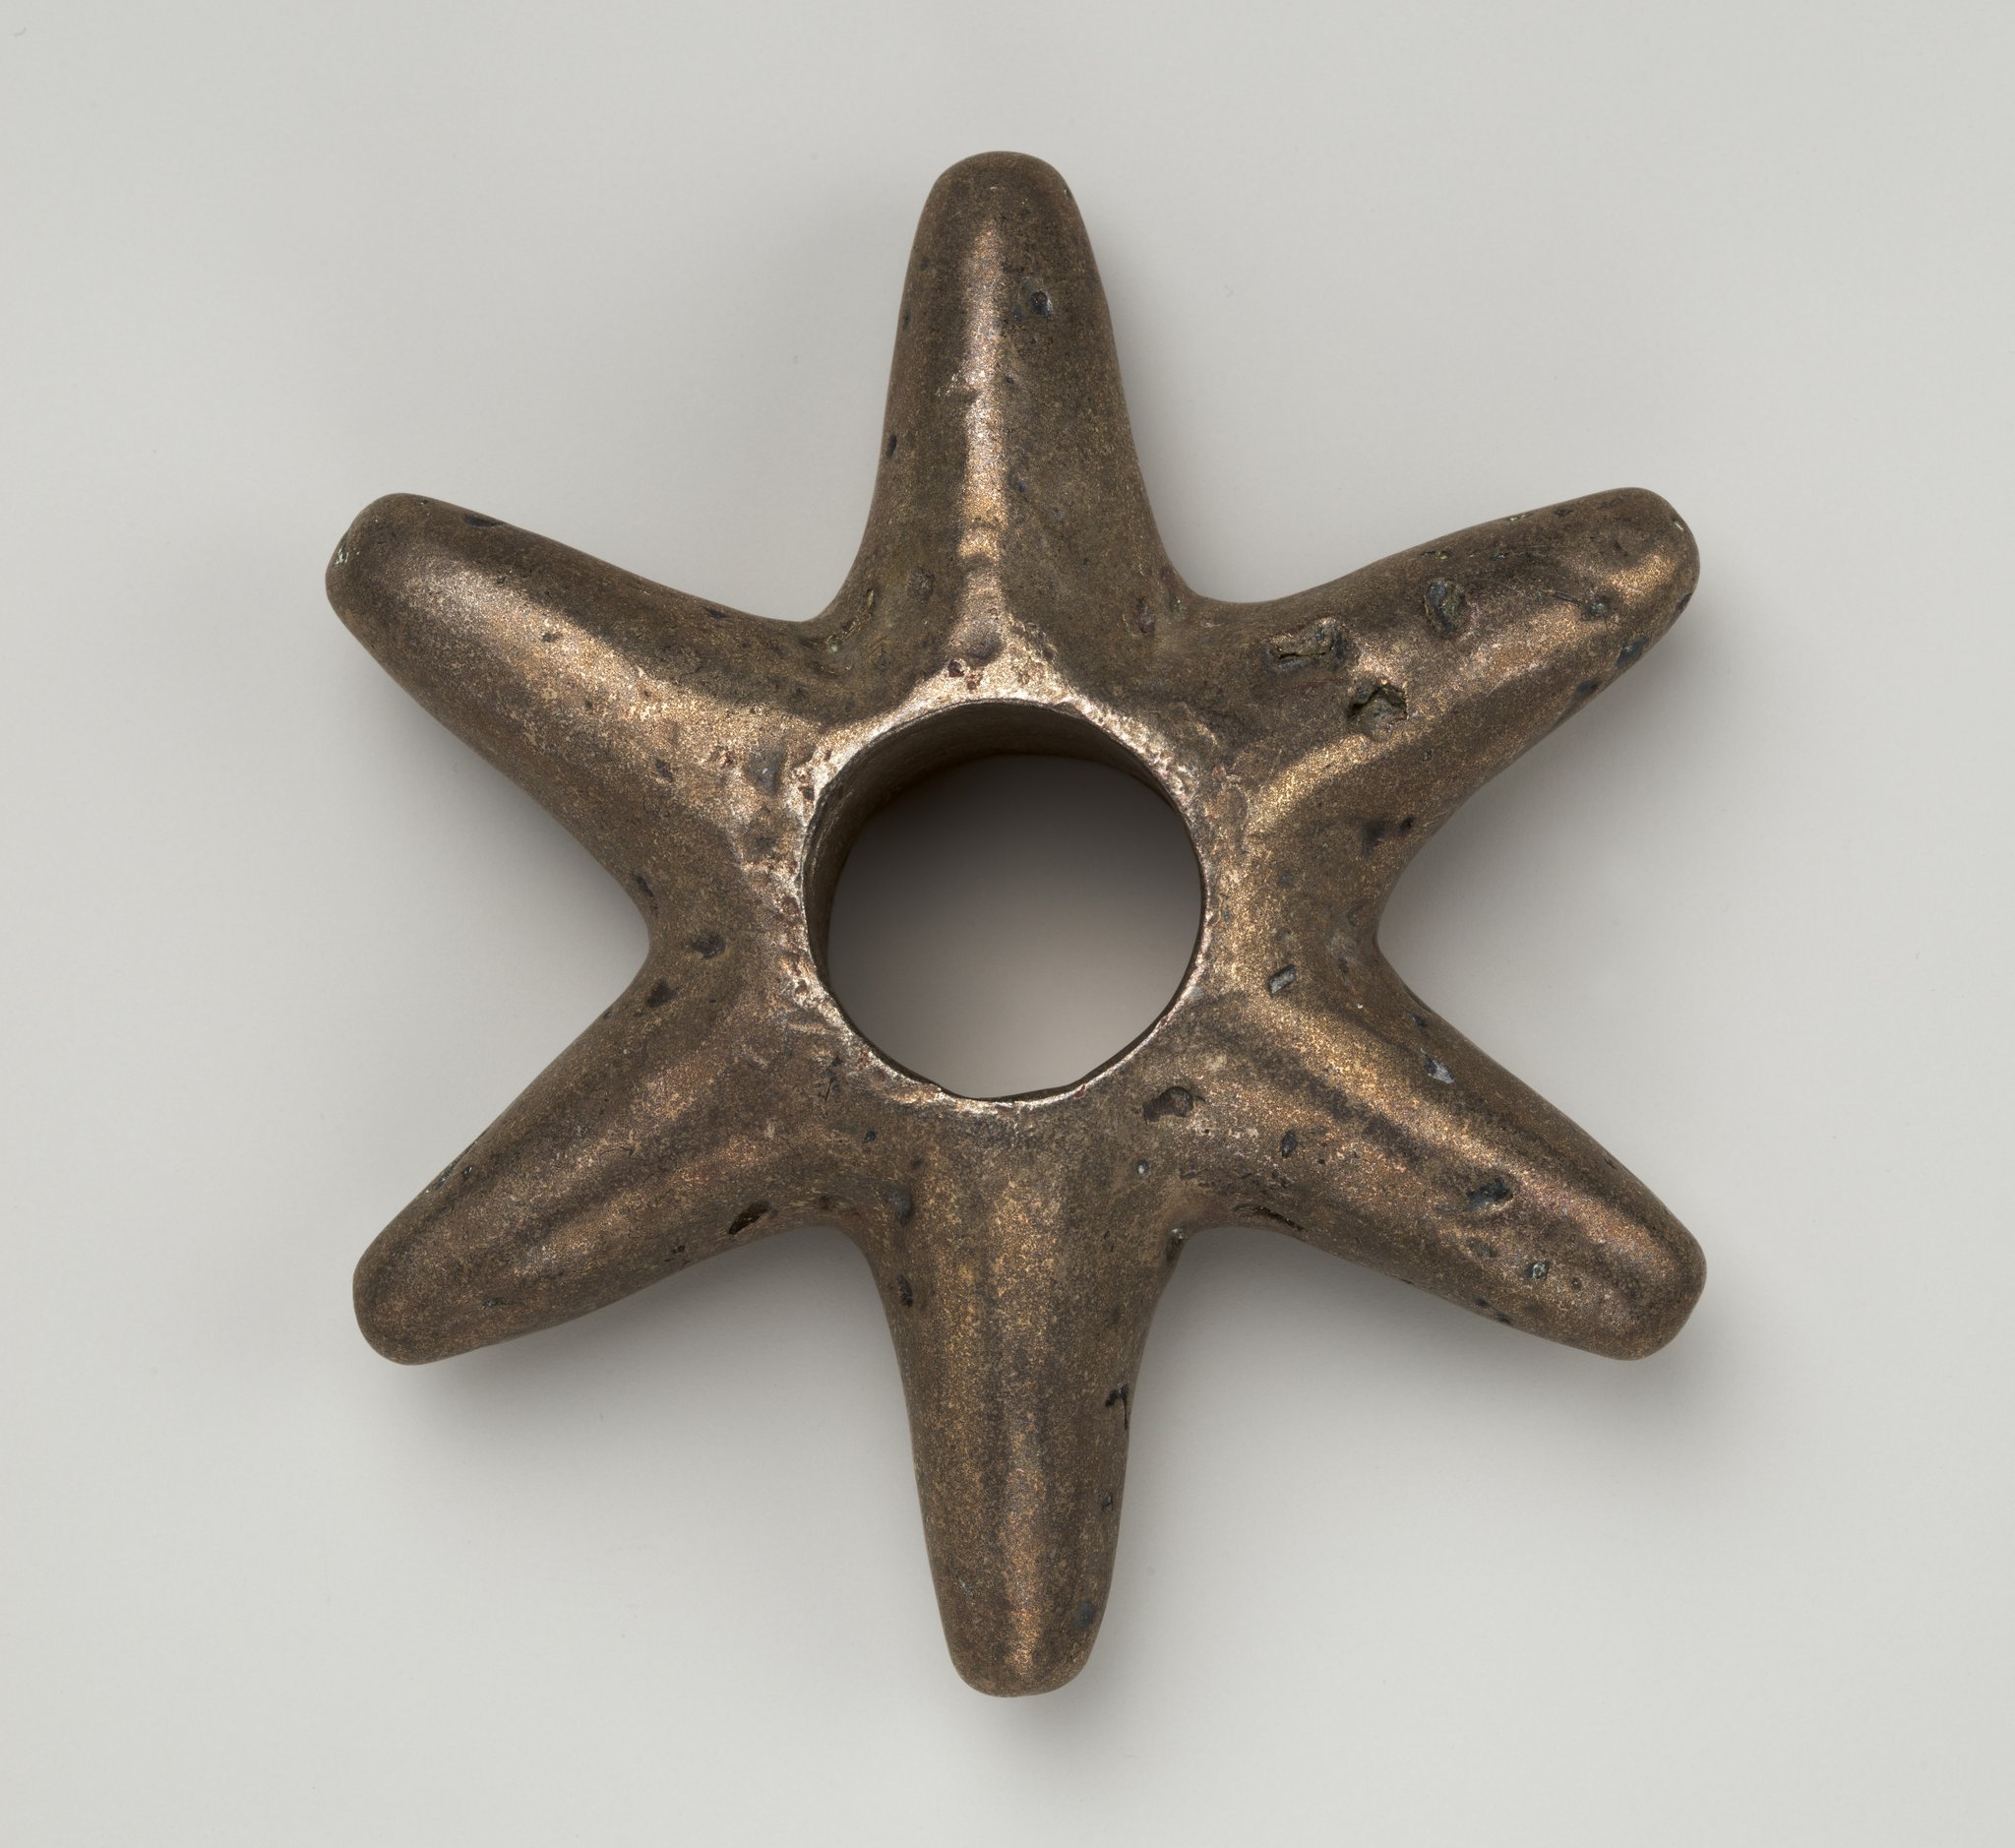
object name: mace head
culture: inca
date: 1401-1600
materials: silver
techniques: casting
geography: ecuador